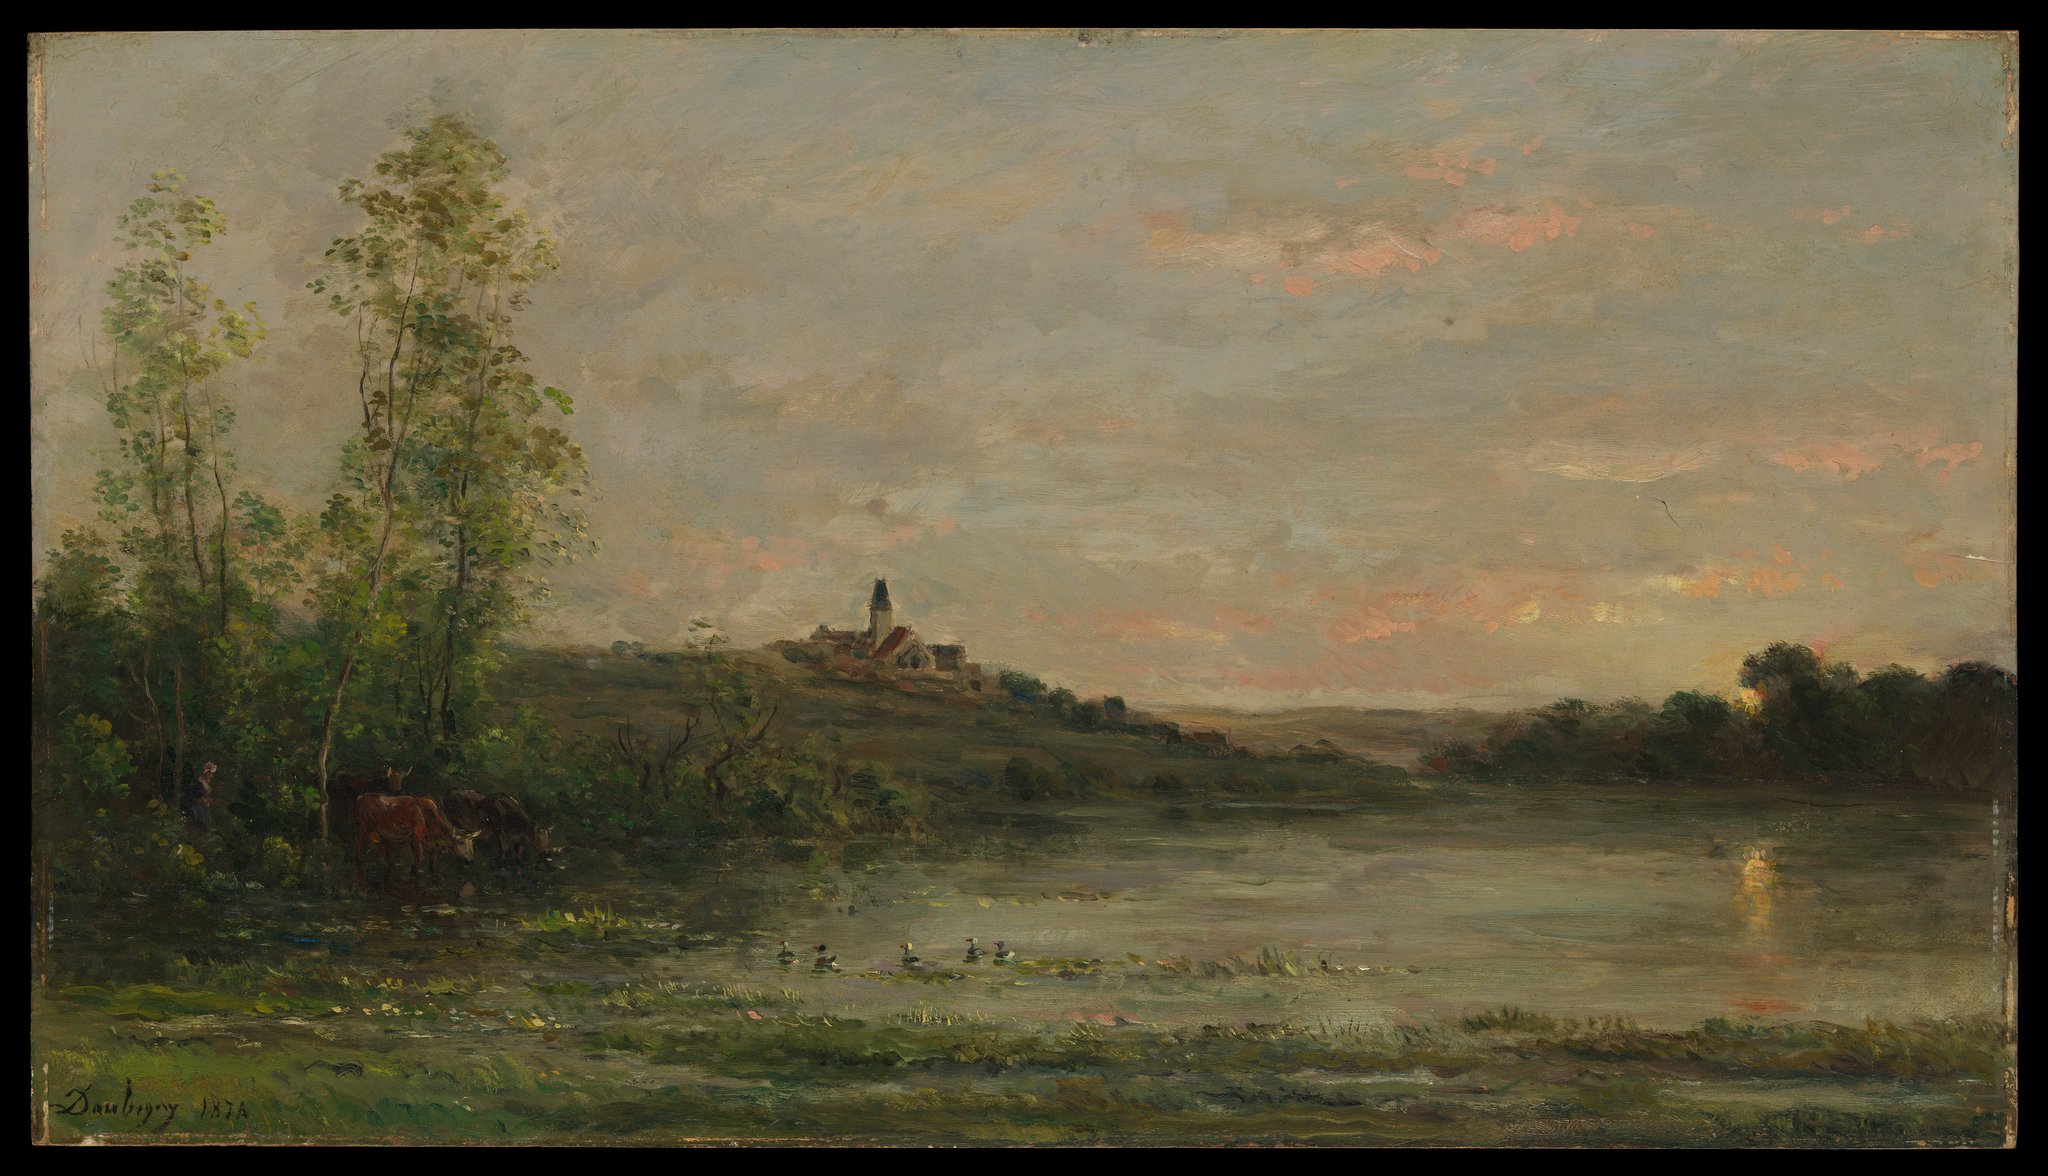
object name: painting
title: The Seine: Morning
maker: charles-françois daubigny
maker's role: artist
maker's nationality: french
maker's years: 1817-1878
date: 1874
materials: oil, wood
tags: rivers,landscapes,morning